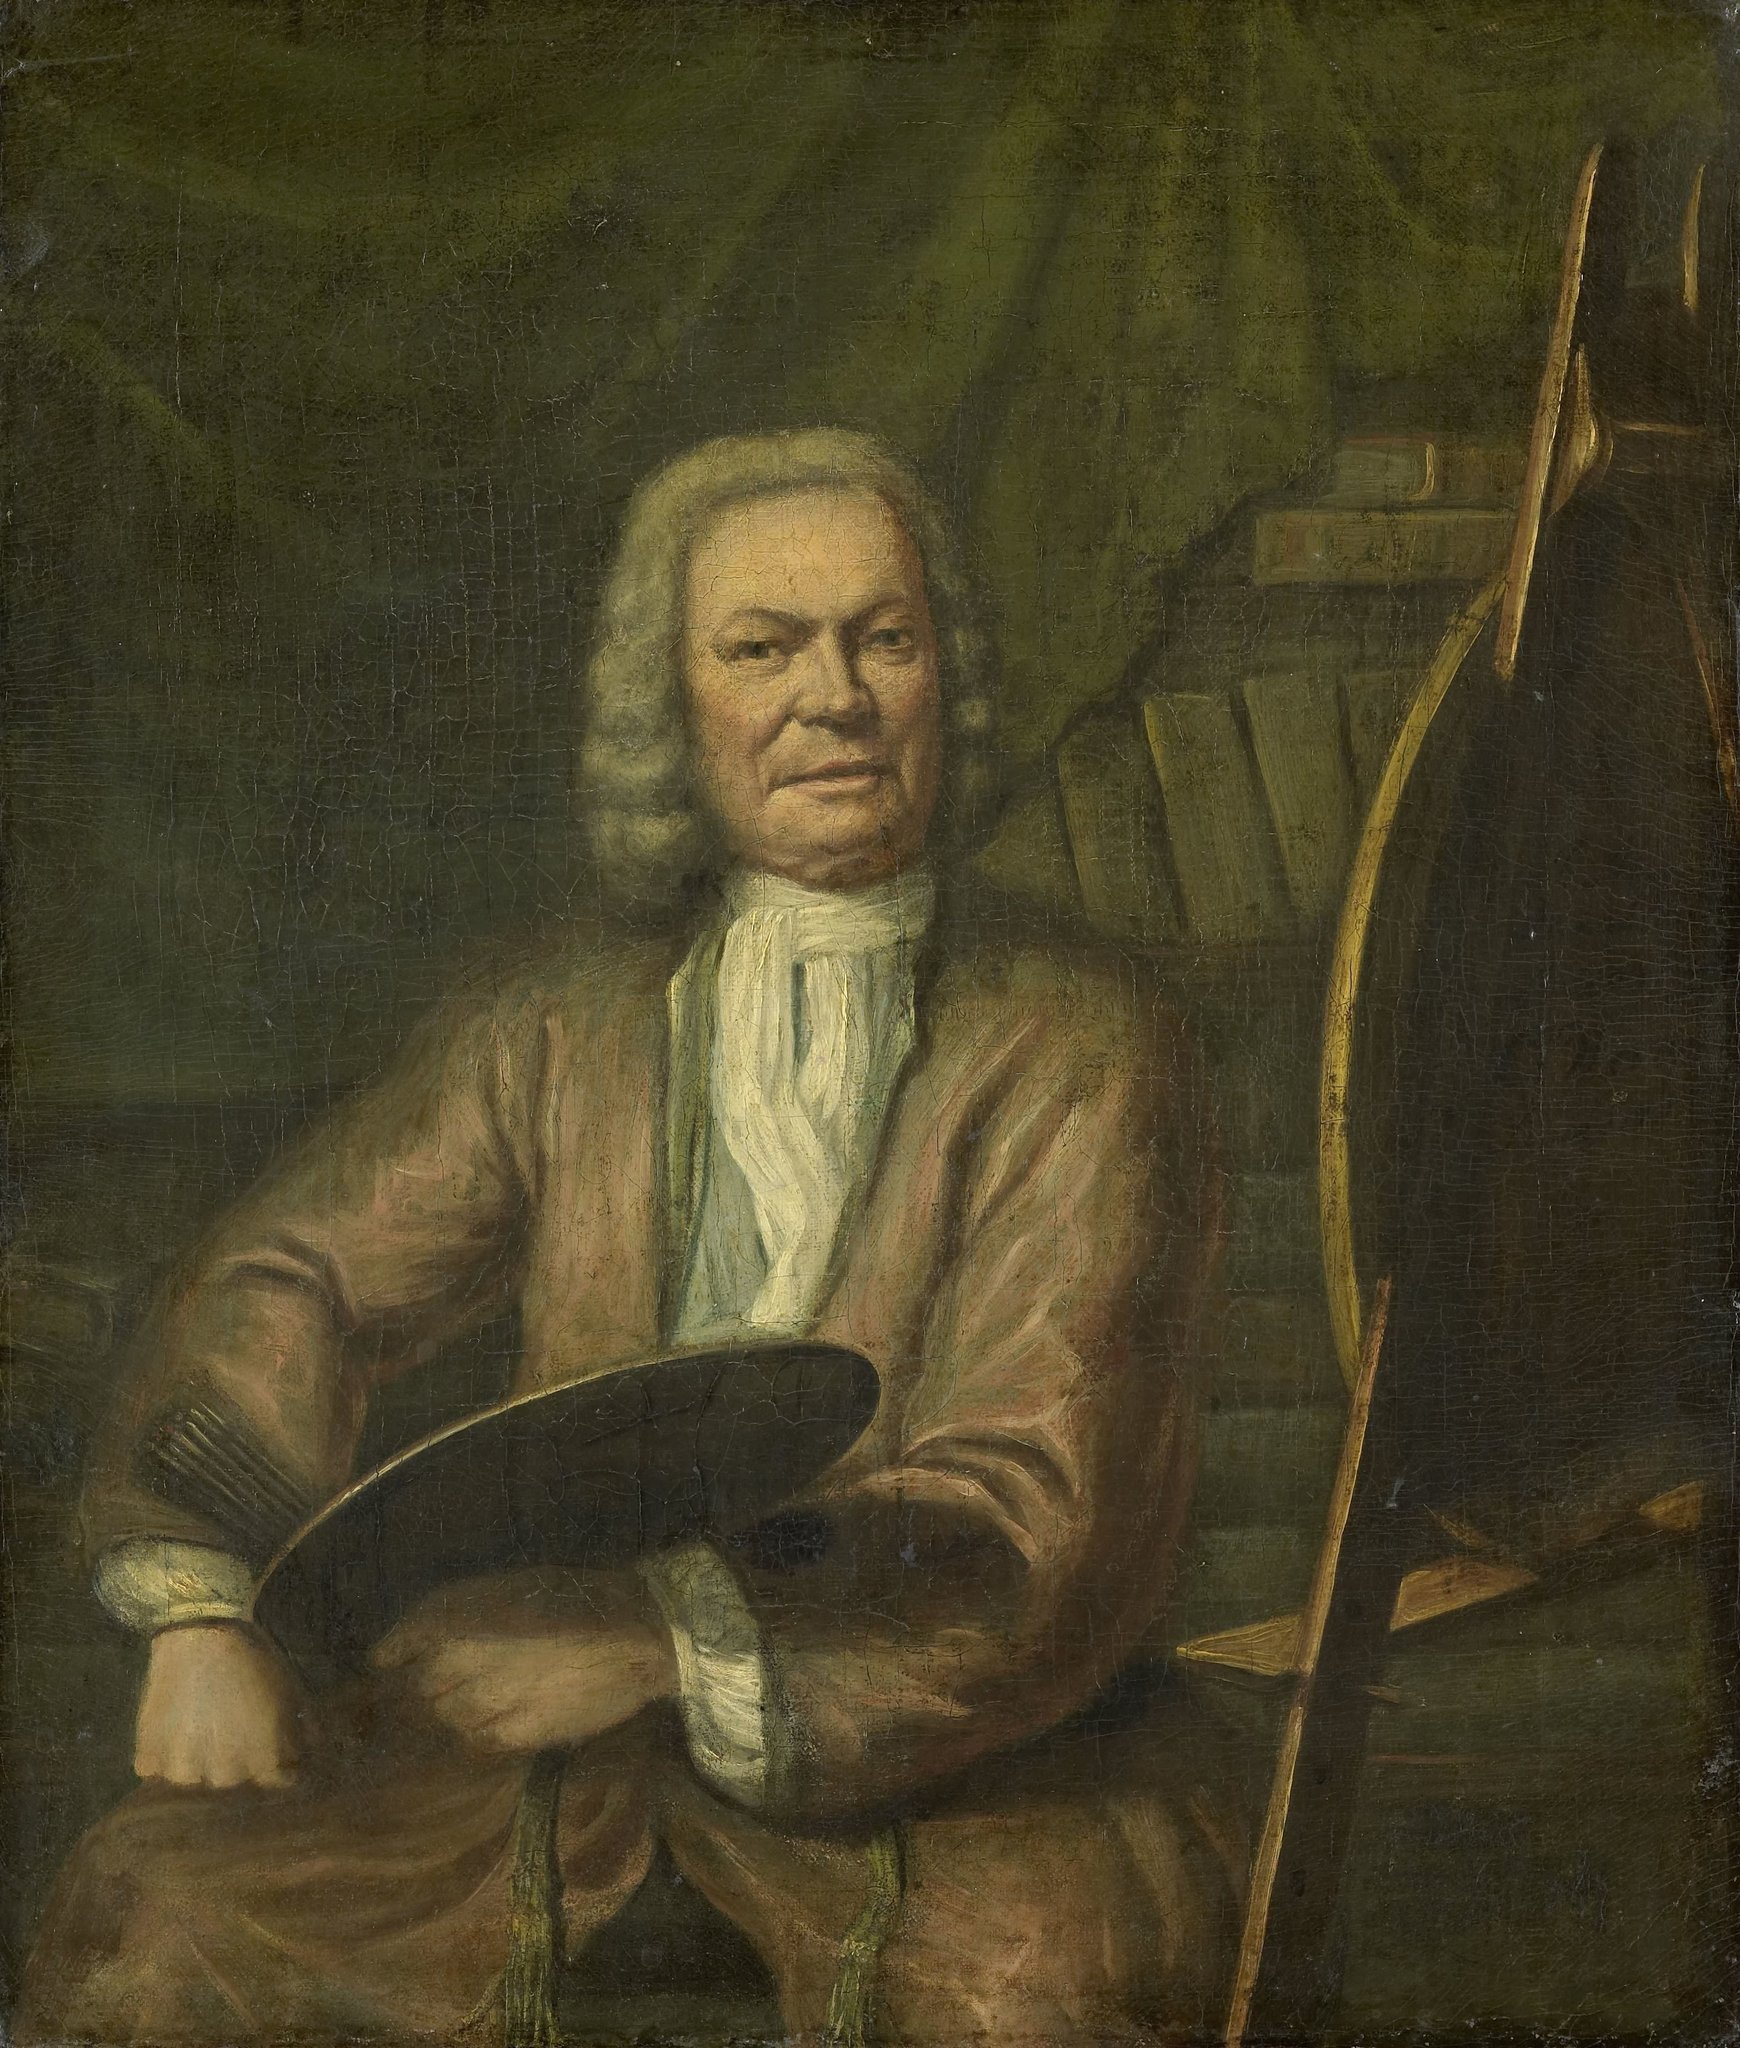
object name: painting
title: Portrait of Jan Maurits Quinkhard, Painter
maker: cornelis wever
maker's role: painter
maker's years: 1748-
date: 1771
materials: canvas, oil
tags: amsterdam, painter, draughtsman, jan maurits quinkhard, historical persons, portrait, self-portrait of painter, portrait, self-portrait of artist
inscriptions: signature, date and inscription: ‘J.M. Quinckhardt Aet. 84 Suae / C. Wever Pinx. 1773’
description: Portret van de schilder Jan Maurits Quinkhard (1688-1772). Kniestuk, zittend achter de ezel in zijn atelier. Op de ezel een ovaal schilderij. Palet en penselen in de linkerhand, op de achtergrond een boekenkast.